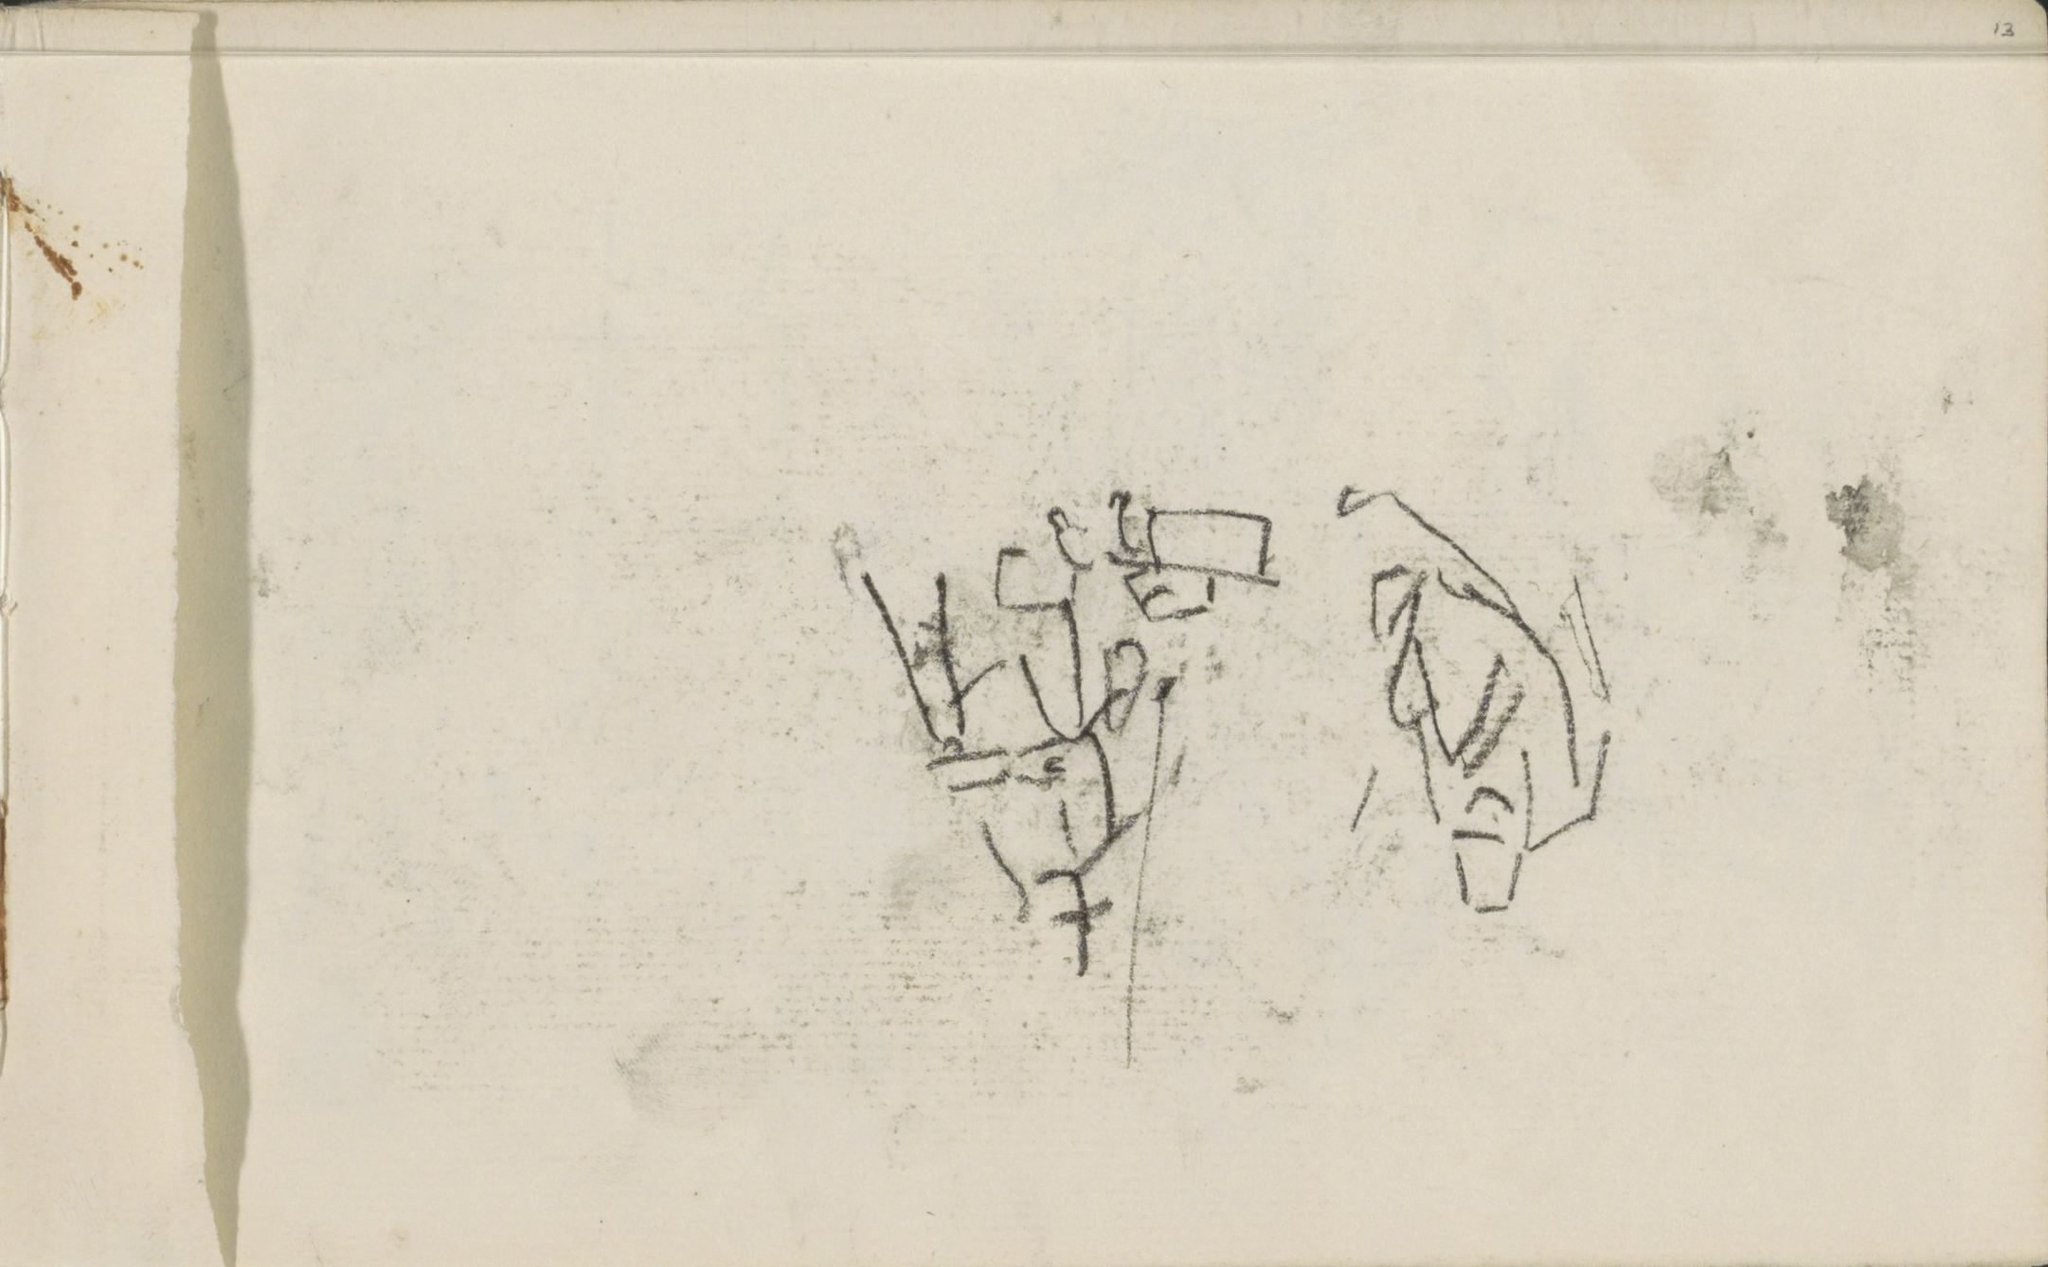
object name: sketchbook leaf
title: Zittende figuren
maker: marius bauer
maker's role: draughtsman, print maker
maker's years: 1867-1932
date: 1877-1885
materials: chalk, paper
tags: sitting figure, head-gear: hat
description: Pagina 13 uit een schetsboek met 8 bladen.